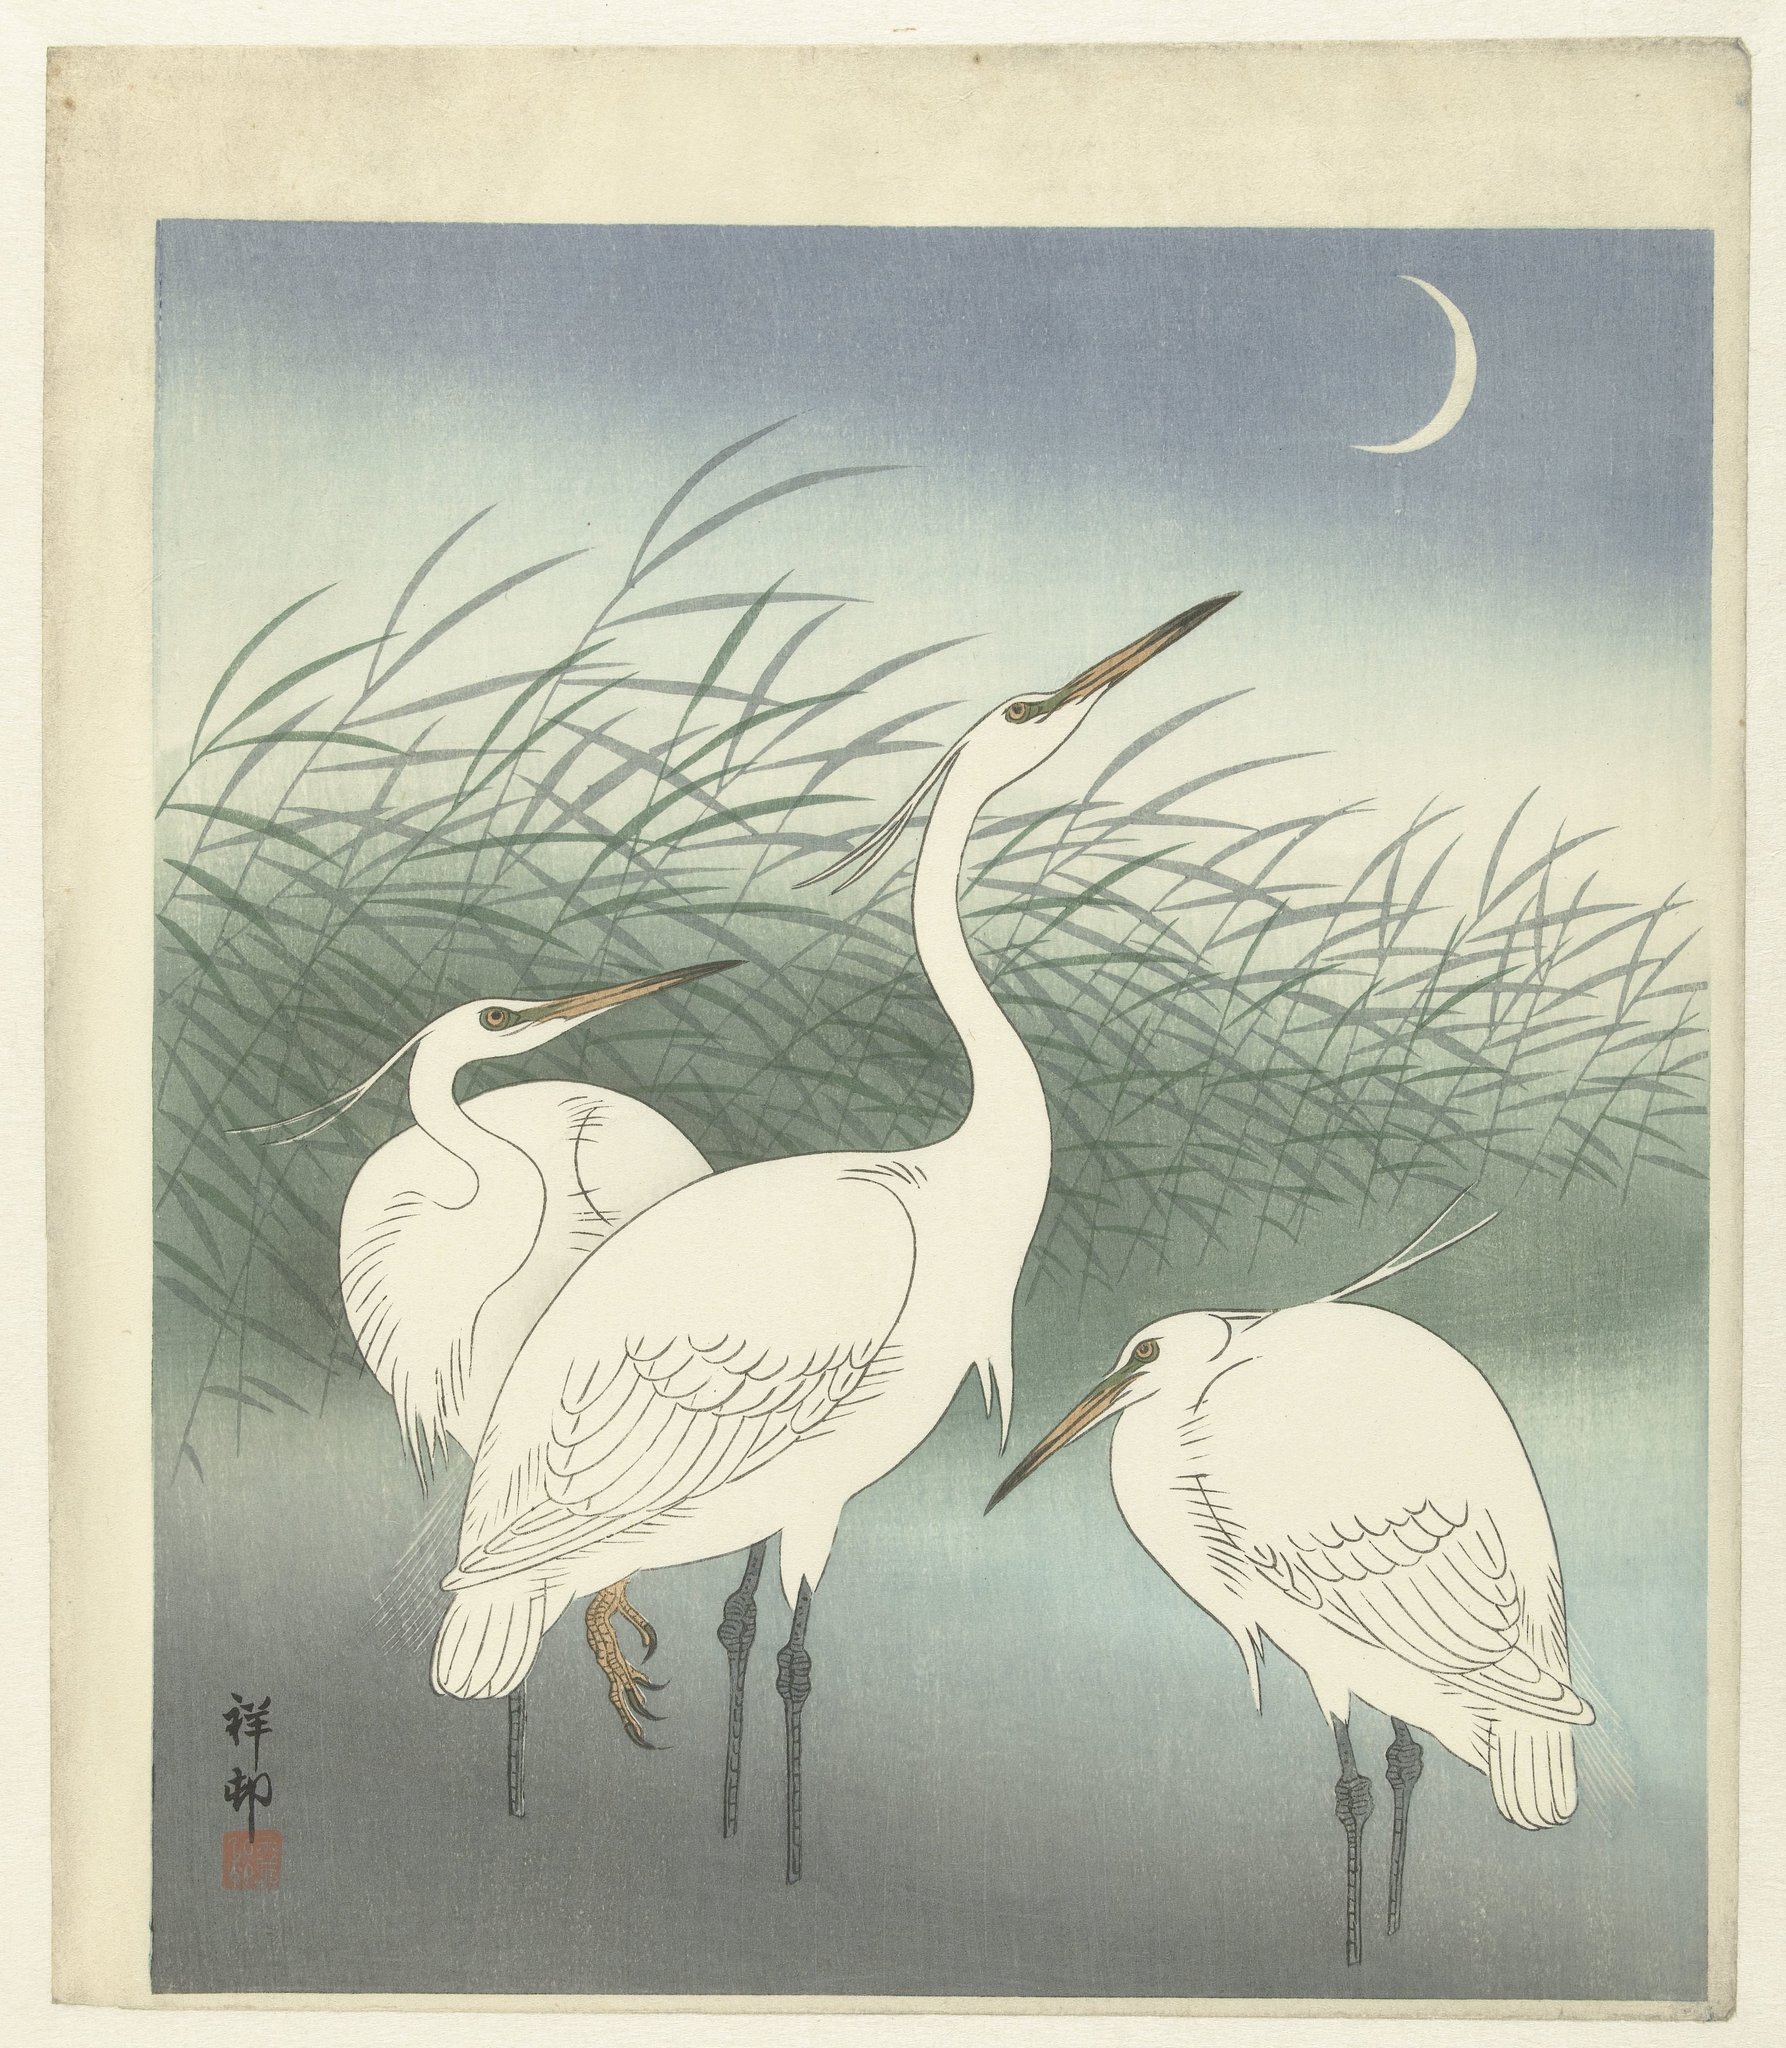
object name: print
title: Reigers in ondiep water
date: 1934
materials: paper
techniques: woodcut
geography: japan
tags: shore-birds and wading-birds: heron, plants and herbs: reed, moon as celestial body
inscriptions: collector's mark: Lugt 2228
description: Drie reigers in ondiep water, bij riet en sikkelmaan.